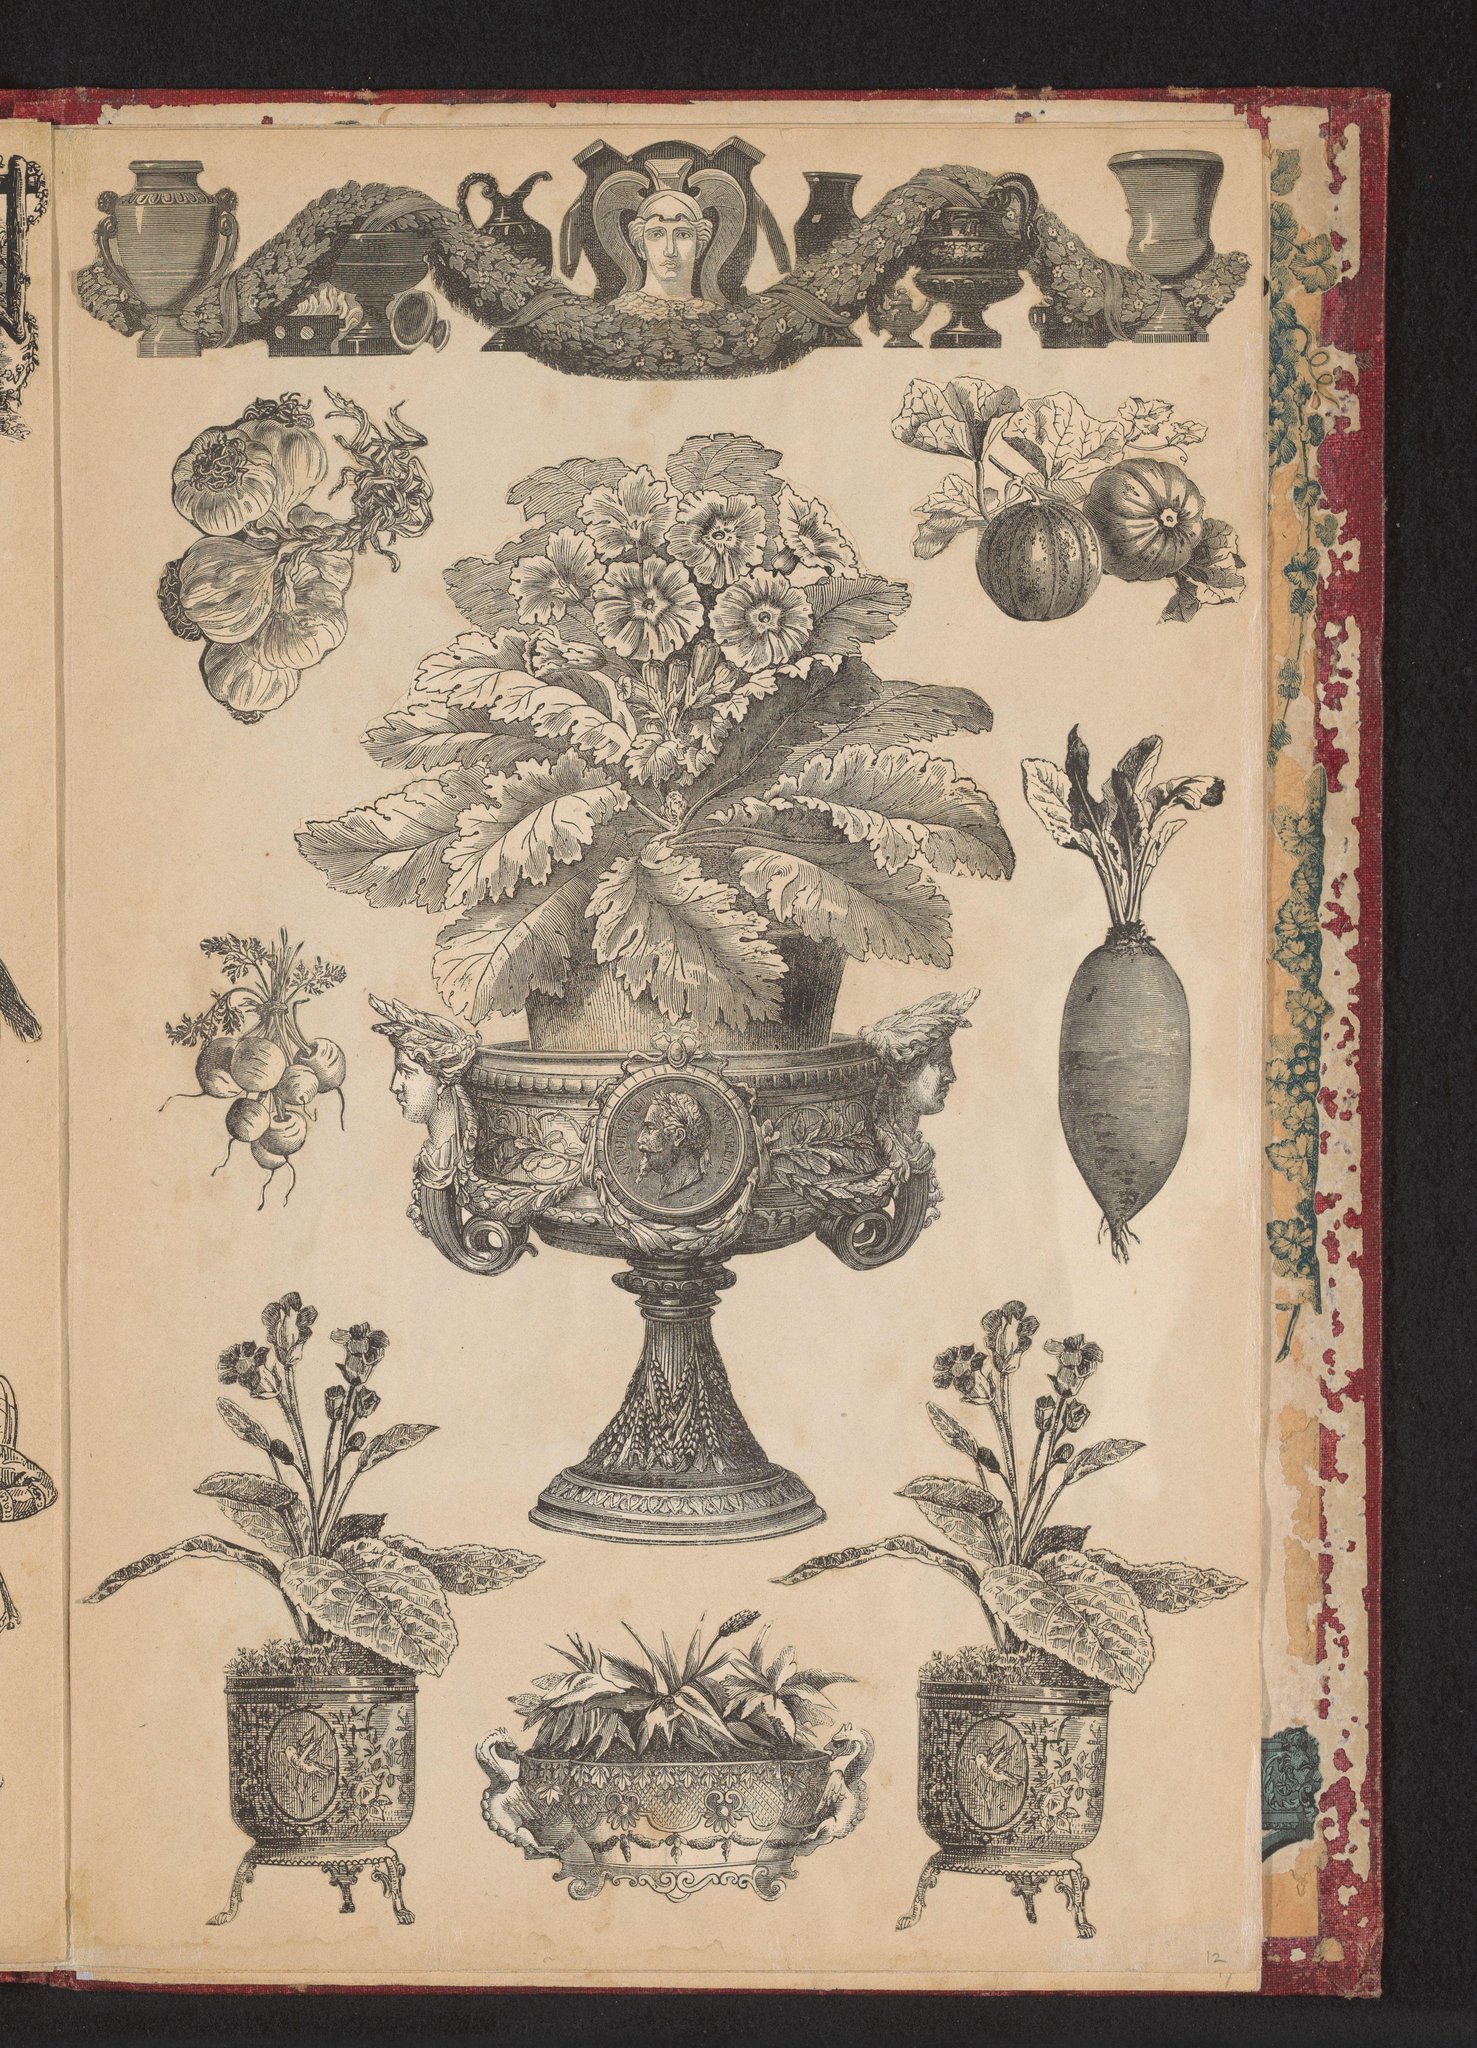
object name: print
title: Collage van uitgeknipte prenten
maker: Anonymous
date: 1870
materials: paper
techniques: engraving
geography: paris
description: Collage van uitgeknipte prenten. Onderdeel van een album met 18 bladen, aan beide zijden beplakt met uitgeknipte prenten, vermoedelijk afkomstig uit 19e-eeuwse tijdschiften.